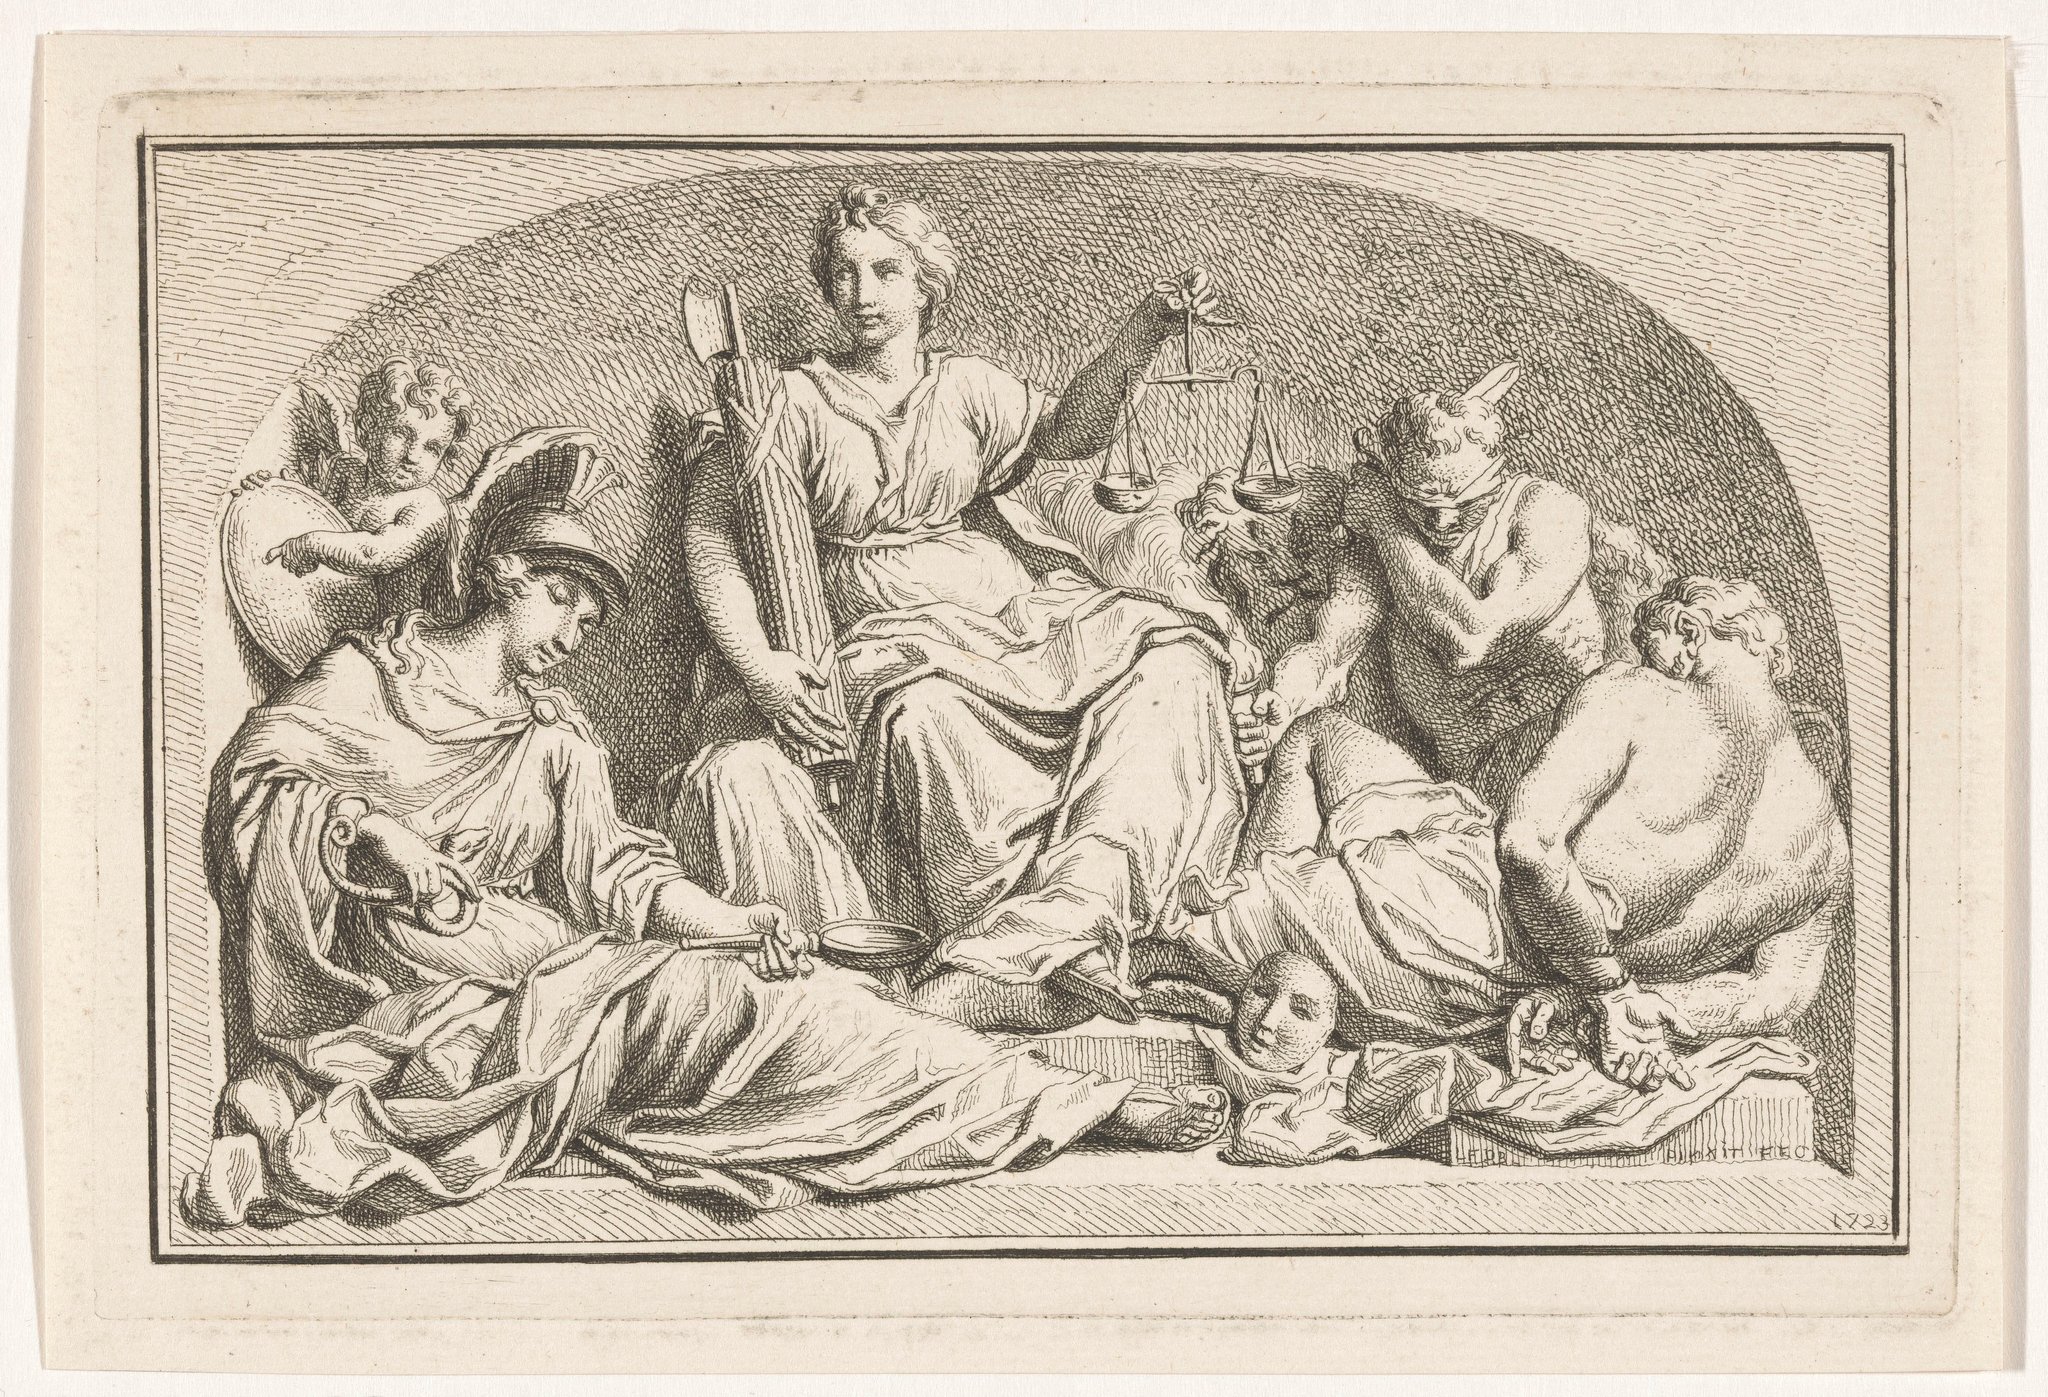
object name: print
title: Allegorie op de gerechtigheid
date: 1723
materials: paper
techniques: etching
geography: amsterdam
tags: justice, 'justitia'; 'giustitia divina' (ripa) ~ one of the four cardinal virtues, the seven deadly sins (personified), prisoner with hands bound, symbols and allegories of jurisprudence (+ 'fasces cum securibus')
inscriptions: collector's mark: Lugt 240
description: In een nis troont Rechtvaardigheid met weegschaal en fasces. Aan haar voeten ligt een geboeide man en naast haar knielt een geblinddoekte man met een toorts in de hand. Links zit een personificatie van ondeugden, met een slang en een handspiegel als attributen.